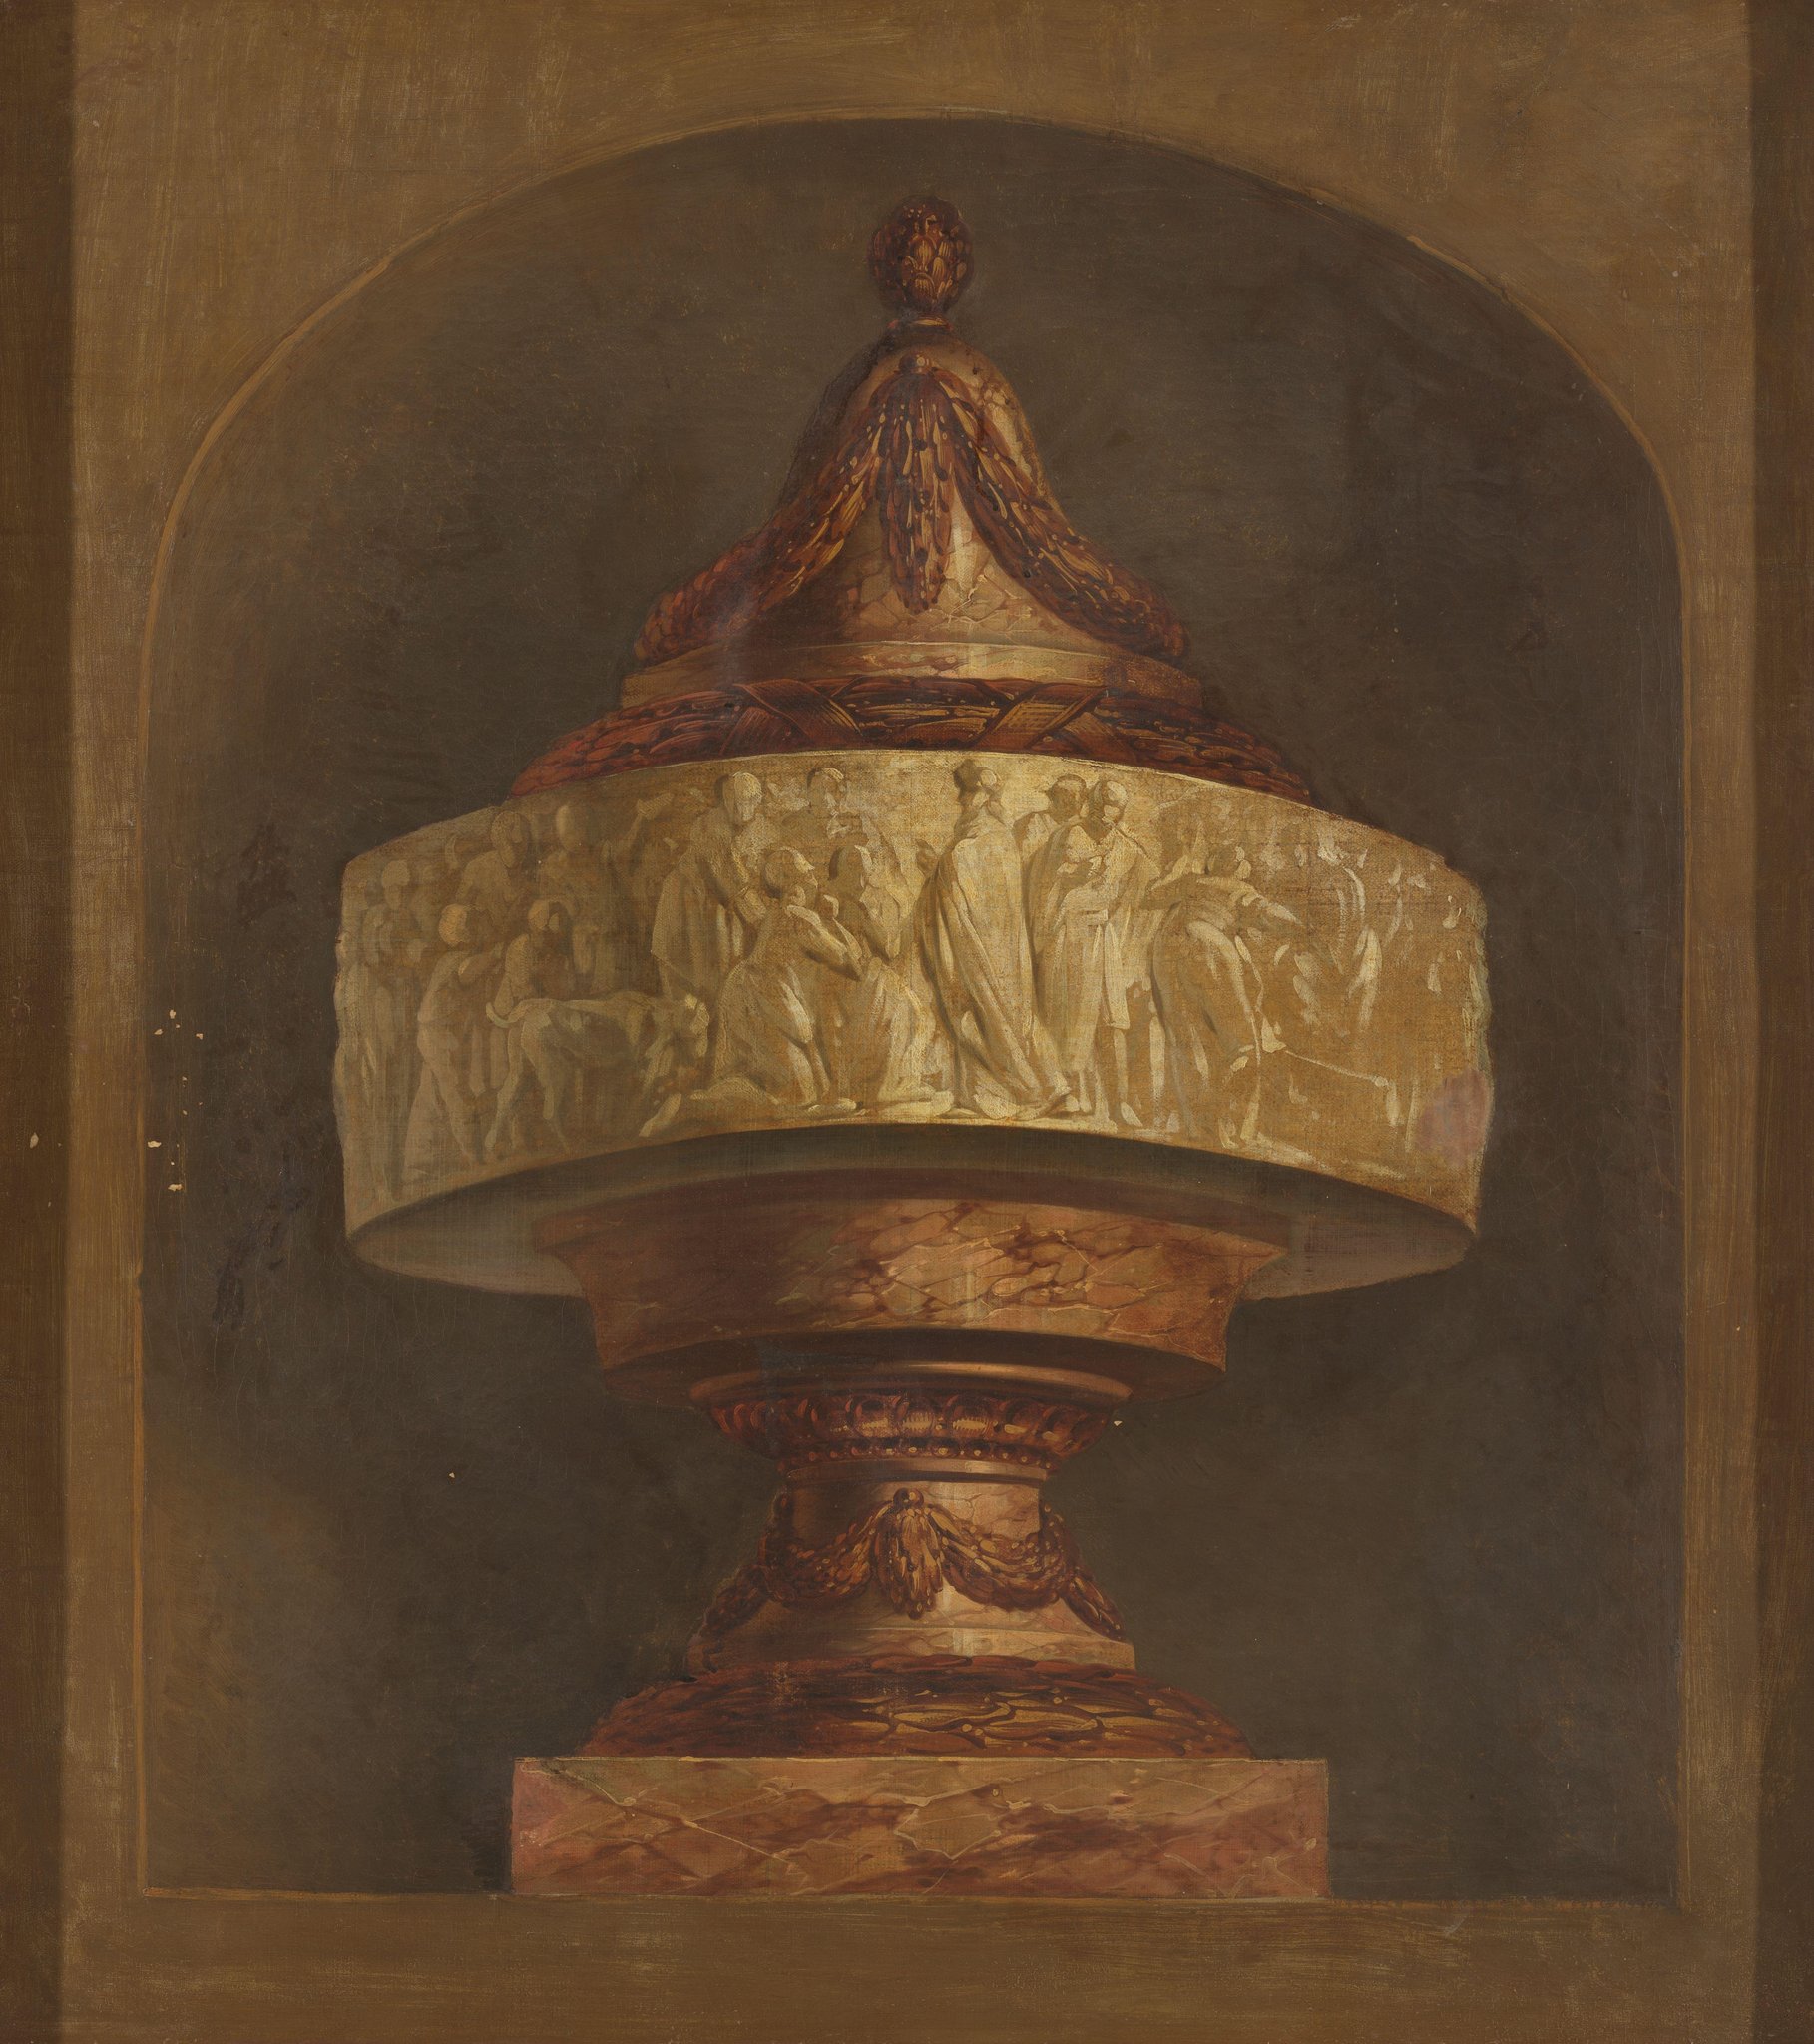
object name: hanging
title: Behangselschildering met siervaas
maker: jurriaan andriessen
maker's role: draughtsman, painter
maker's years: 1742-1819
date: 1776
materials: canvas, oil, paint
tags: netherlands